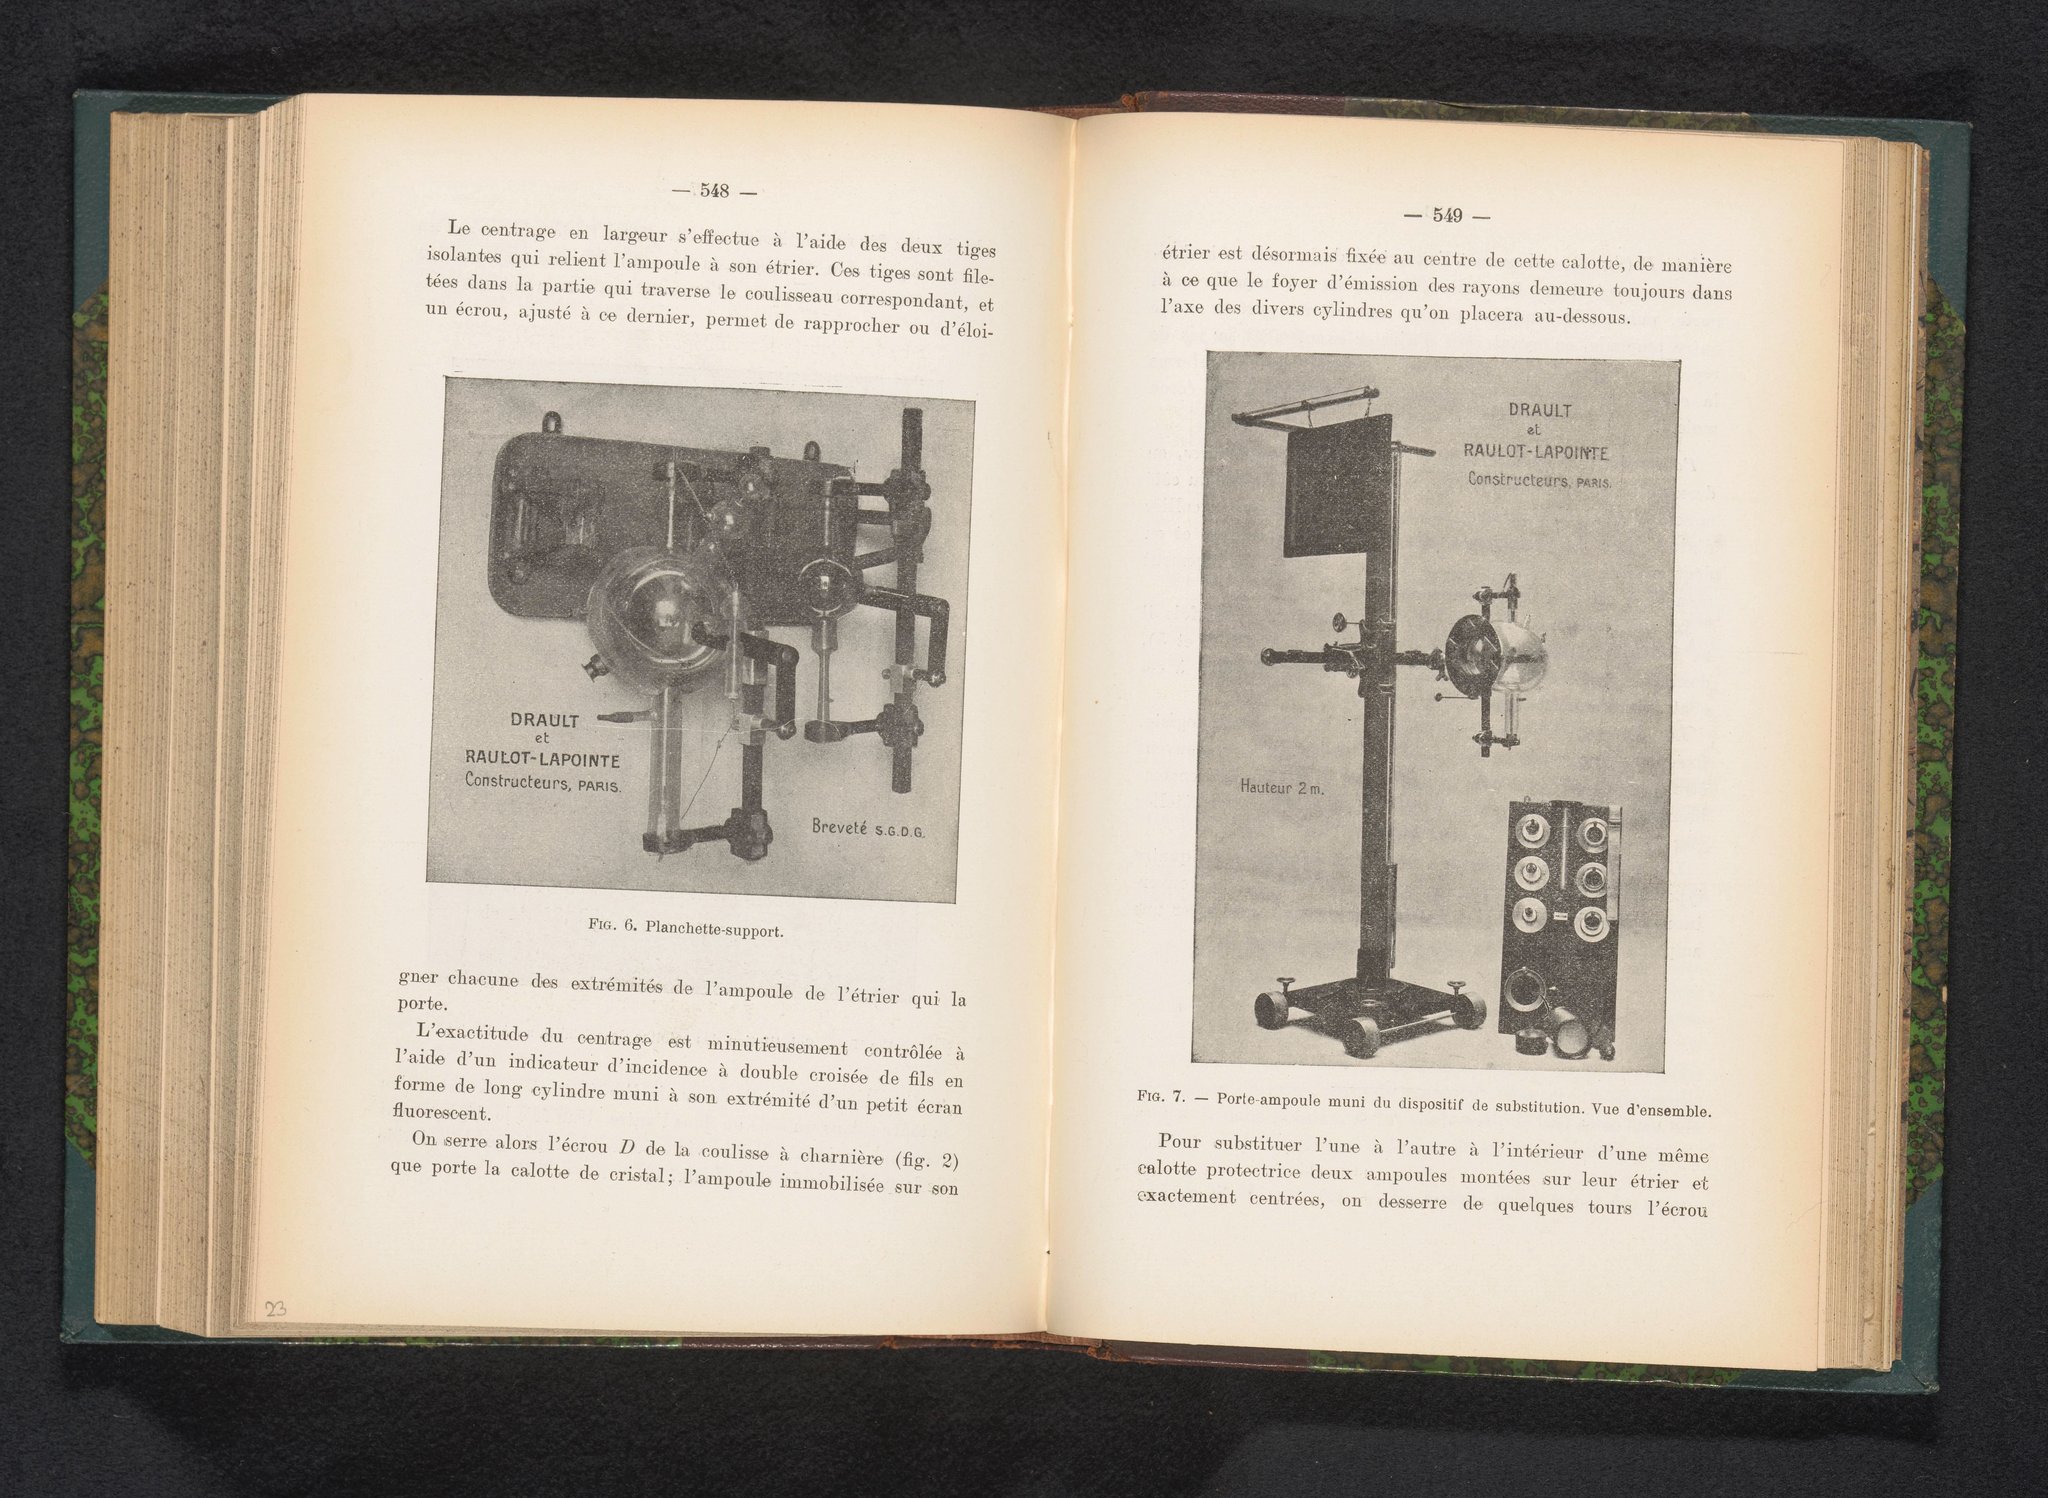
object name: photomechanical print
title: Ondersteuningsbord van een gereedschap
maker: Anonymous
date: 1904-1909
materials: paper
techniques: autotype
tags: parts of machines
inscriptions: inscription: ‘Fig. 6. Planchette-support’, inscription: ‘DRAULT/ et/ RAULOT-LAPOINTE/ Constructeurs, Paris/ Bréveté S.G.D.G.’